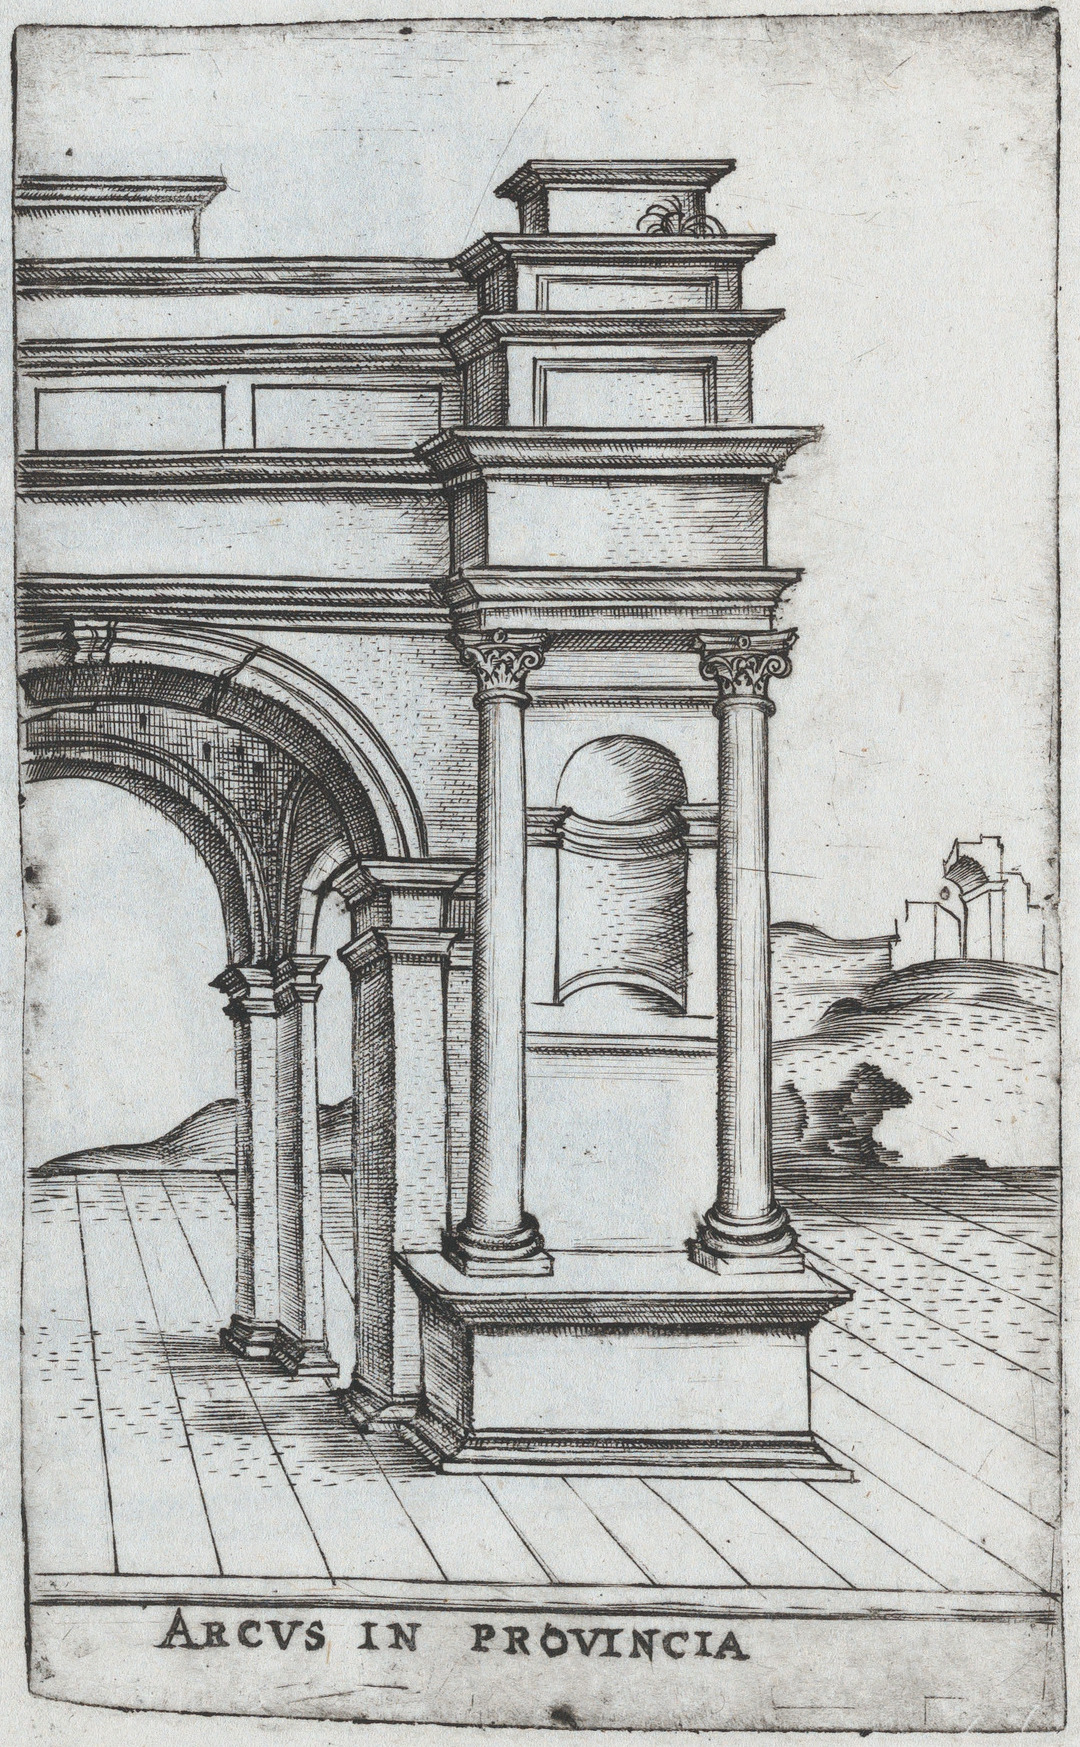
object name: album print ornament architecture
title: Arcus S. Georgii, from a Series of Prints depicting (reconstructed) Buildings from Roman Antiquity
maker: monogrammist g.a. with the caltrop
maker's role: artist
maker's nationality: italian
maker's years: 1535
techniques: engraving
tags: architecture,arches